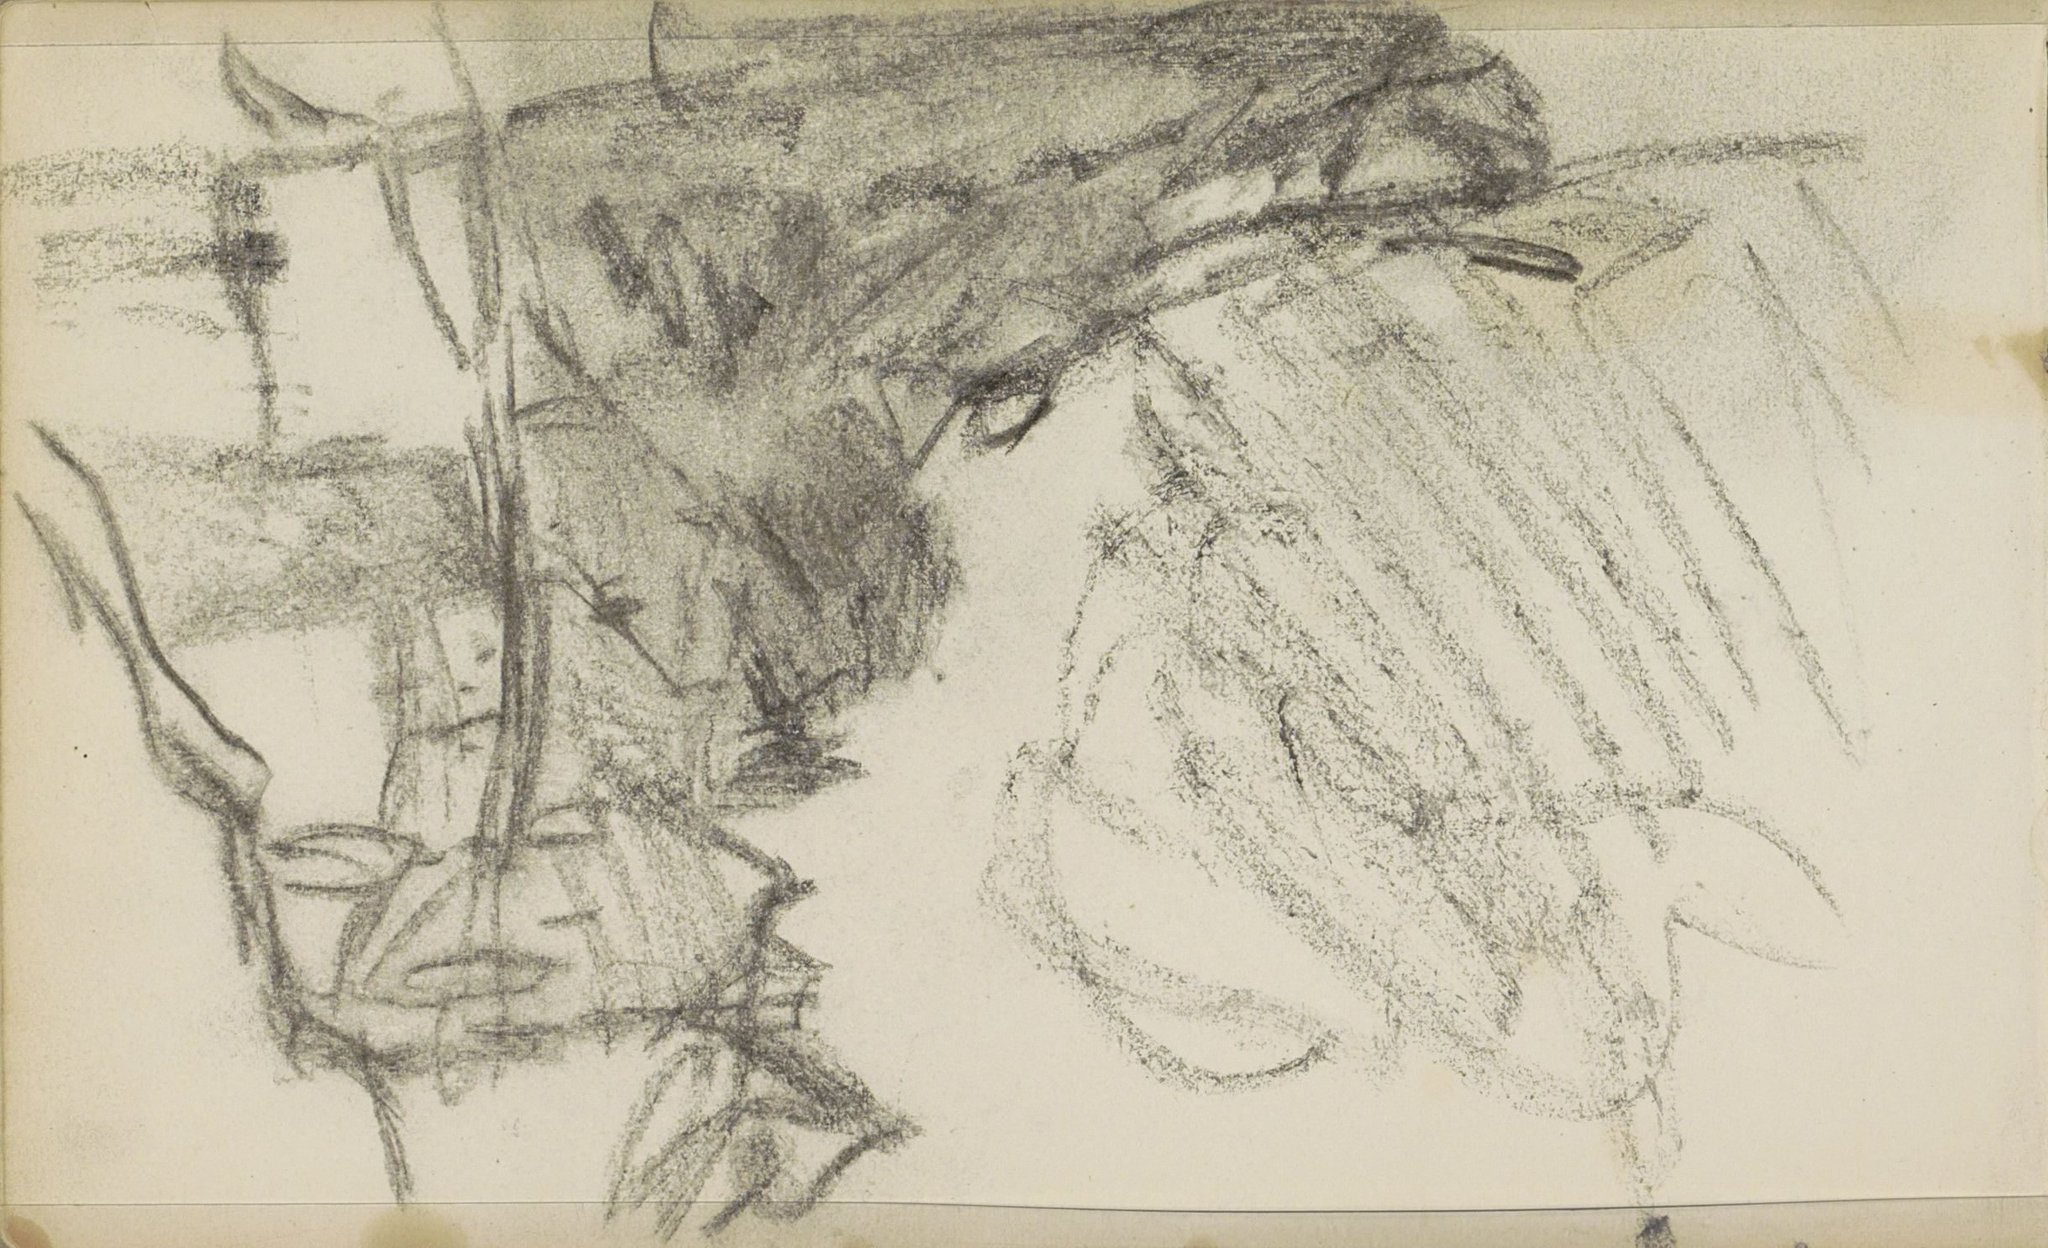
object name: sketchbook leaf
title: Studie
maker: jozef israëls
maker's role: draughtsman, painter, print maker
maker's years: 1824-1911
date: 1834-1911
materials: chalk, paper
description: Blad 36 verso uit een schetsboek met 42 bladen.